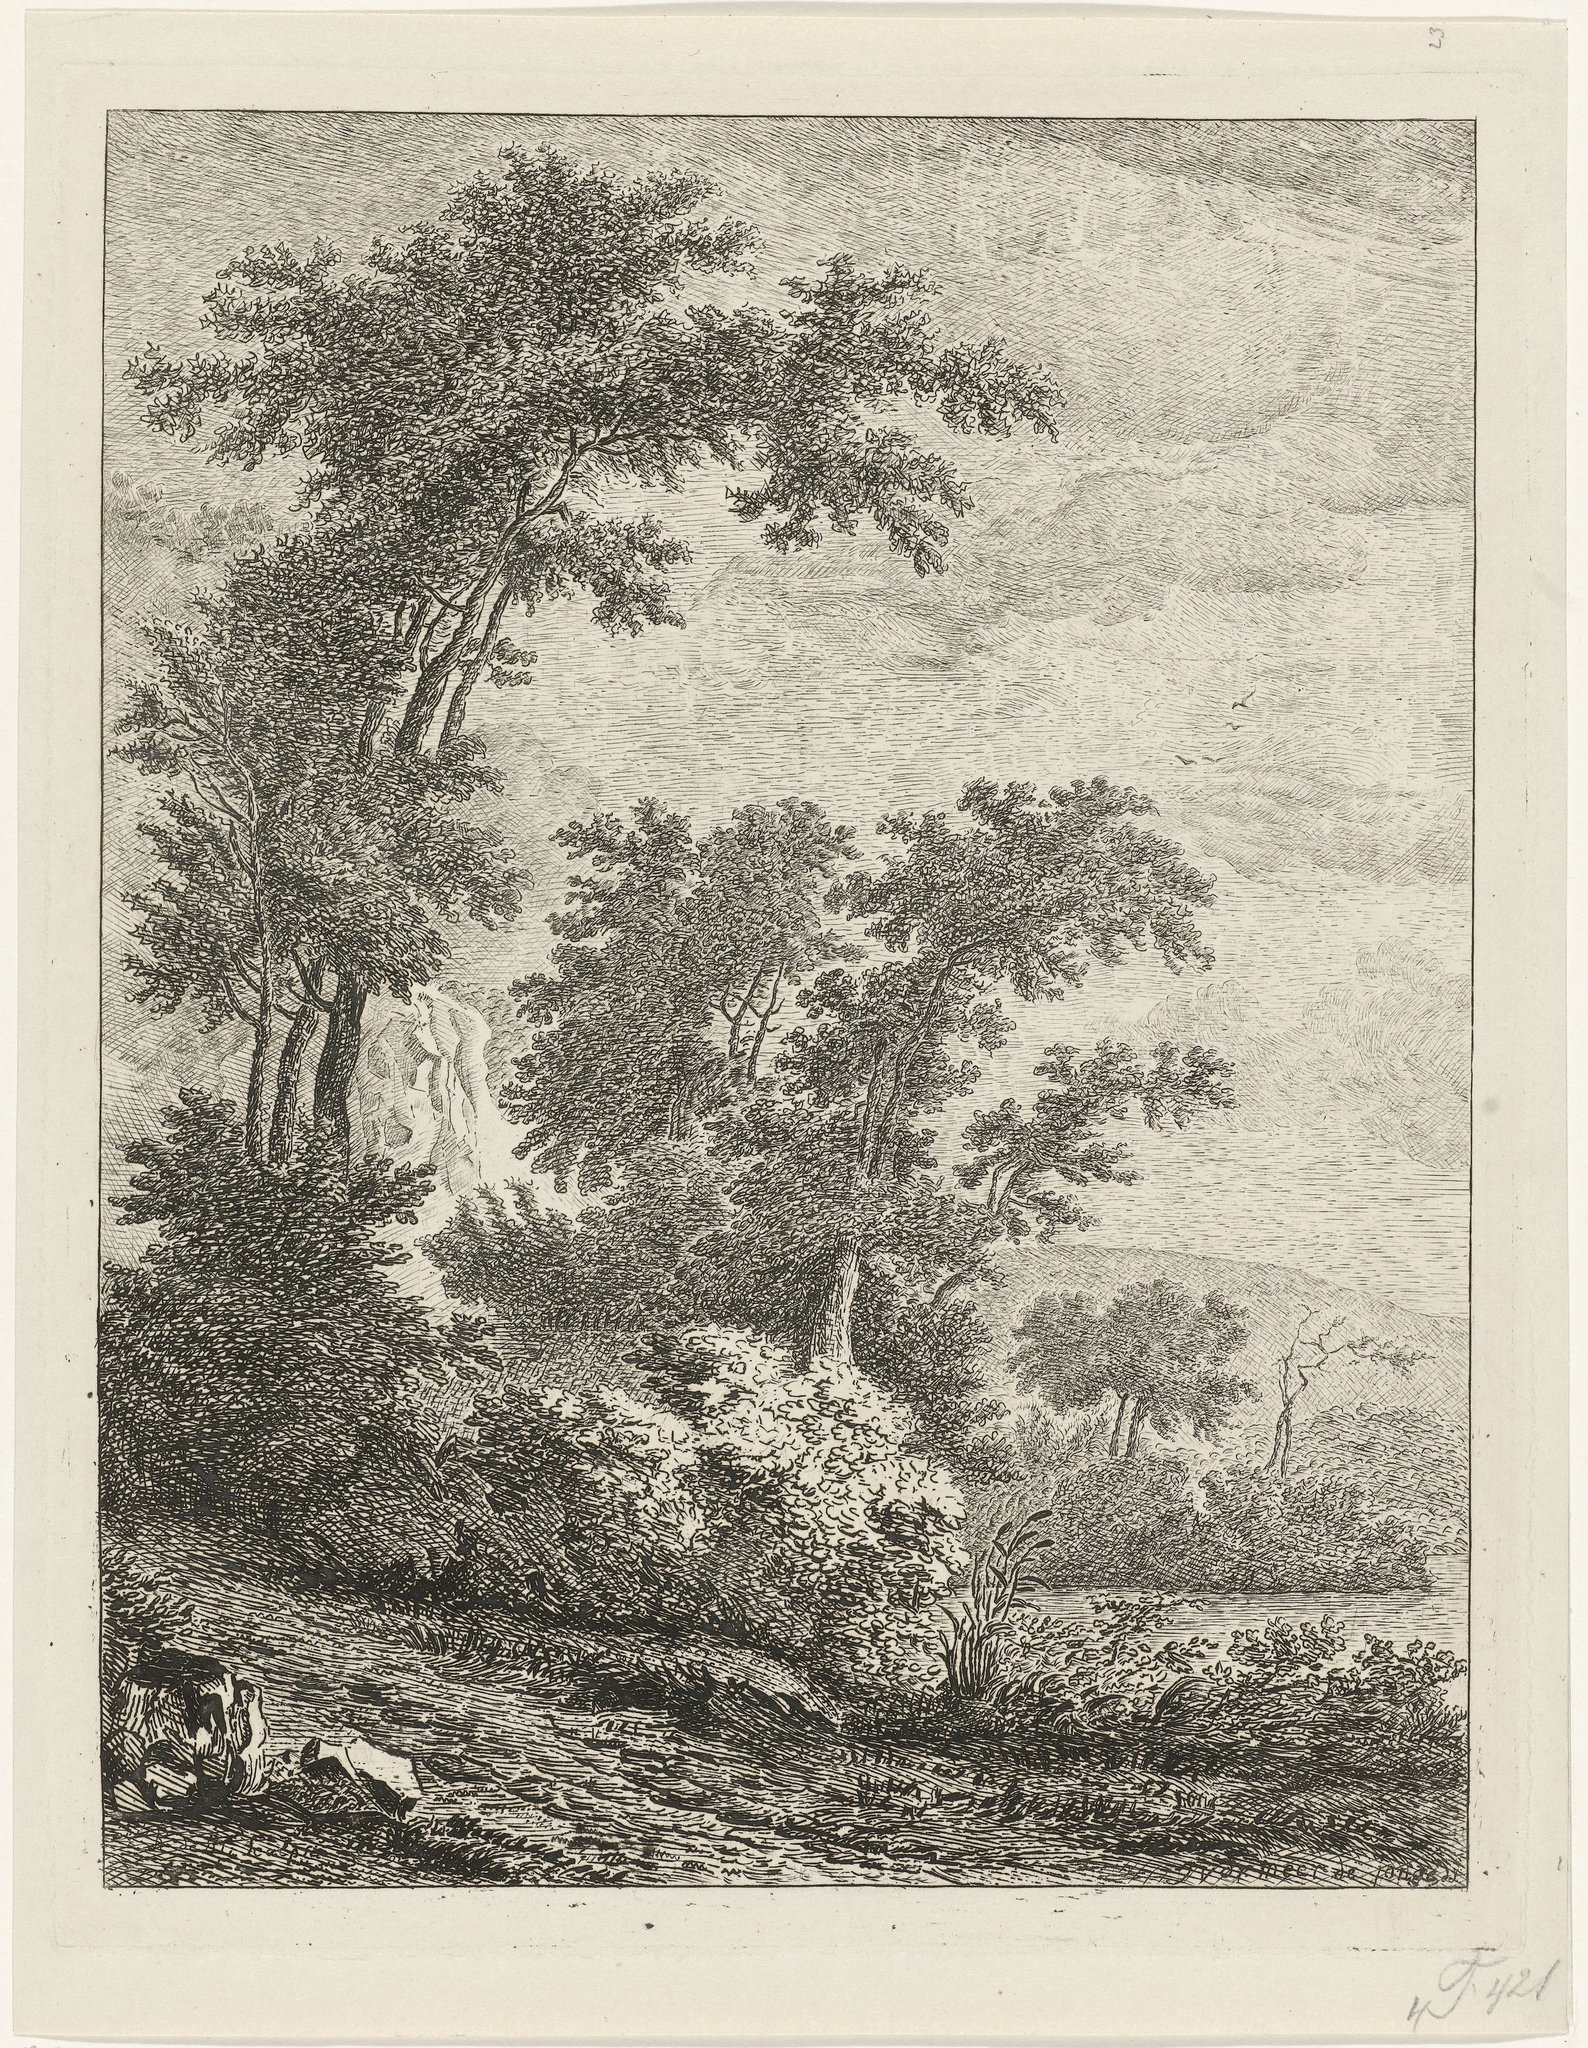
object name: print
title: Landschap met hoge bomen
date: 1796-1856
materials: paper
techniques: etching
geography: vaassen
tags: trees, landscapes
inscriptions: collector's mark: Lugt 2228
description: Landschap met hoge bomen en links water.